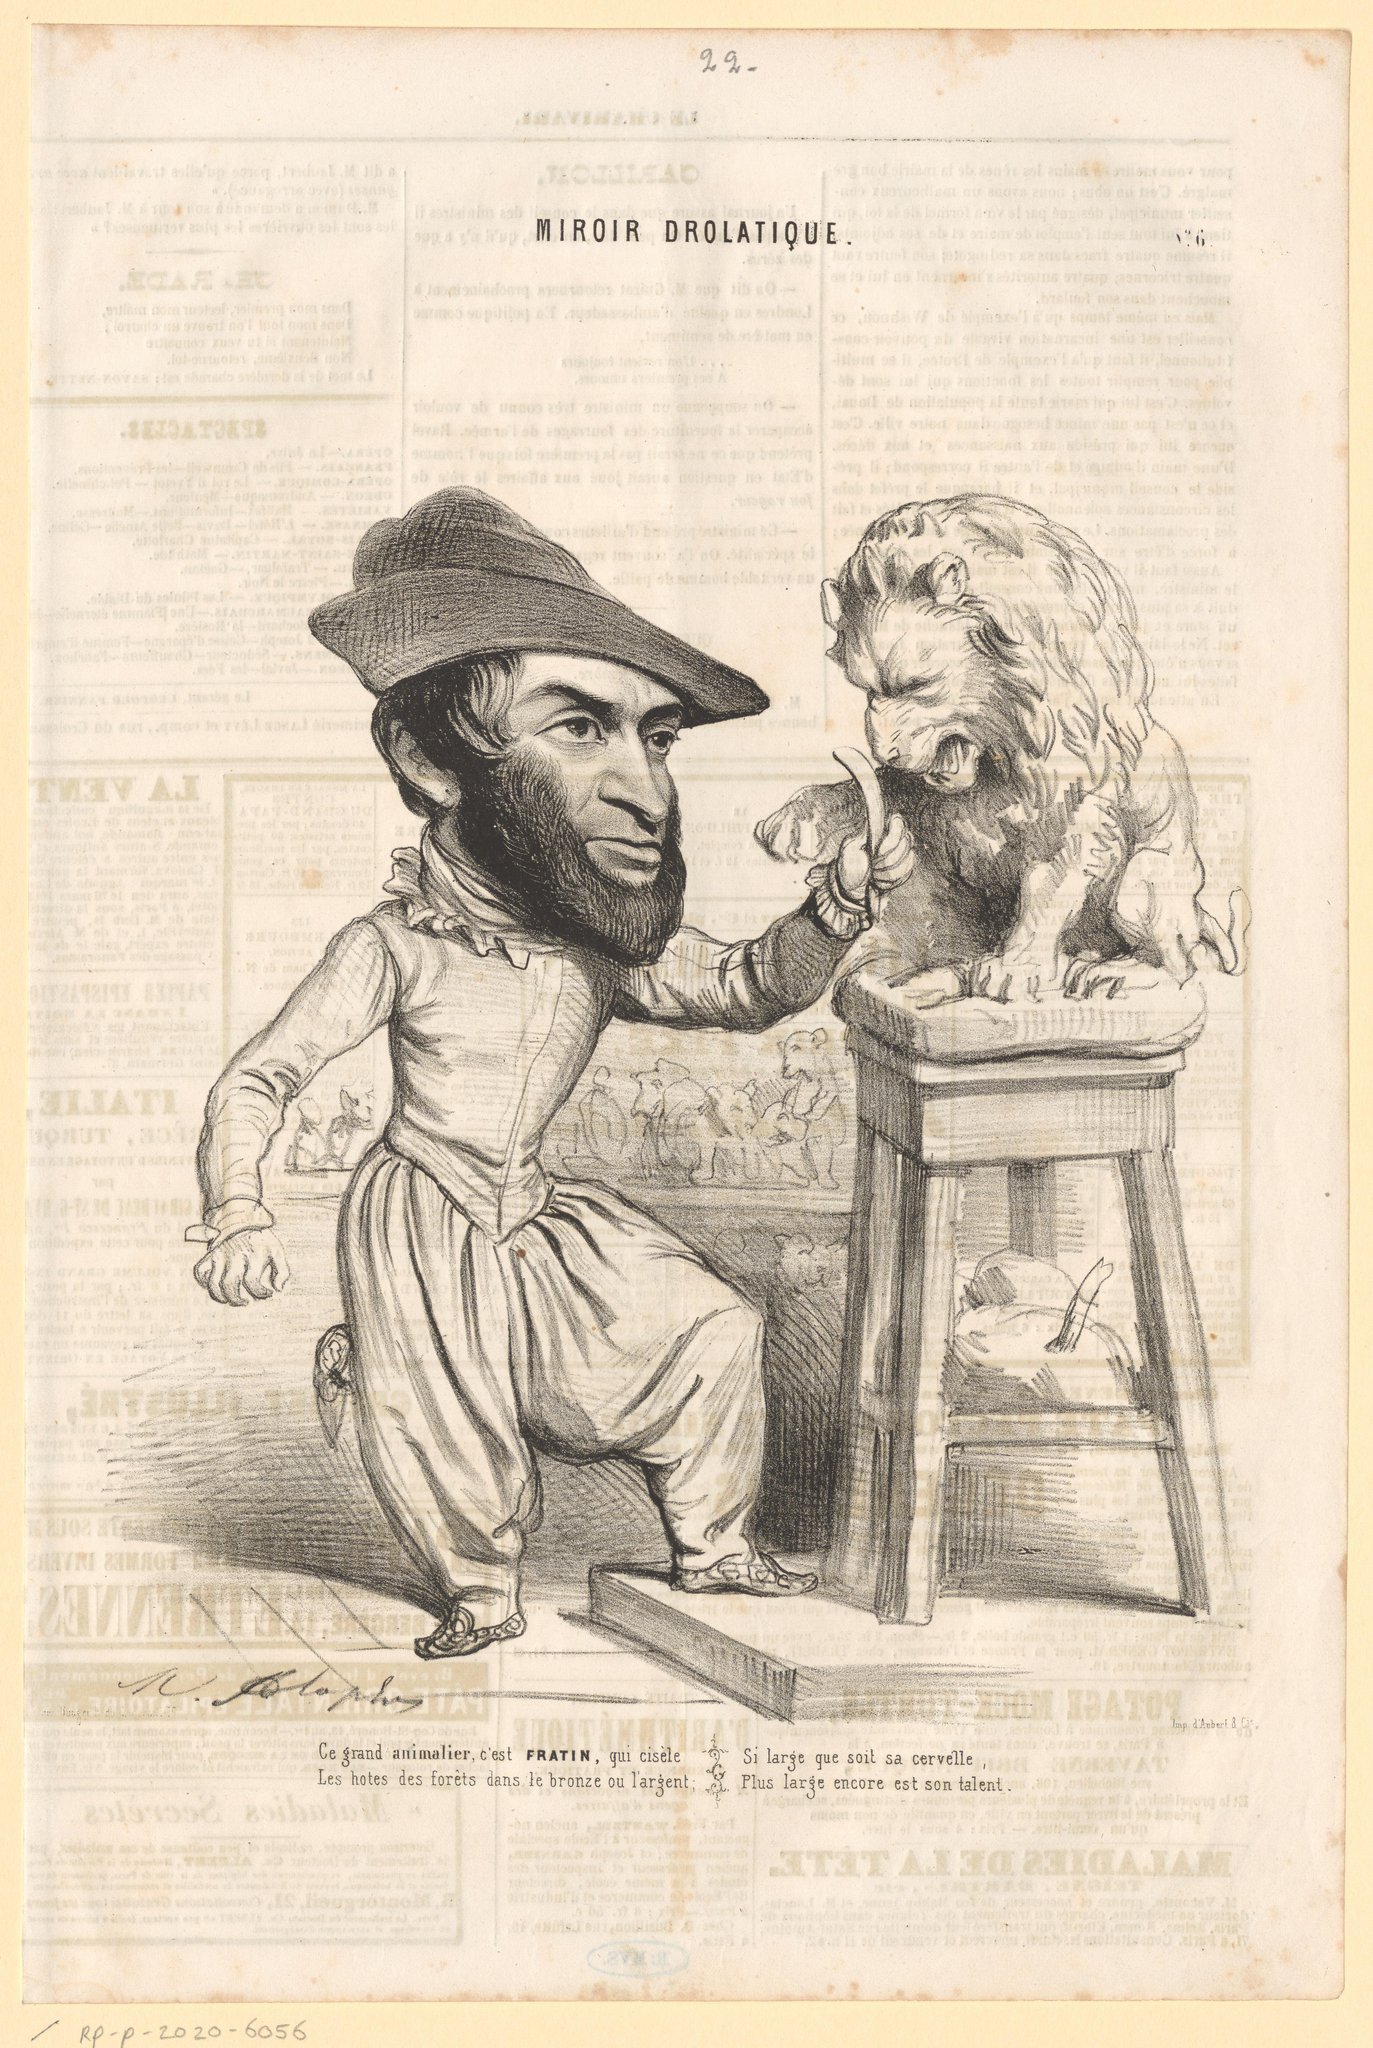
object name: cartoon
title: Grappige spiegel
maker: marie alexandre alophe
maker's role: print maker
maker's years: 1811-1883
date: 1842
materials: paper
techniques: letterpress printing, lithograph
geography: paris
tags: sculptor, christophe fratin, sculptor at work, caricatures (human types), historical persons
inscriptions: collector's mark: Lugt 2228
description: Rechtsboven genummerd: No. 6. Met onderschrift in het Frans.